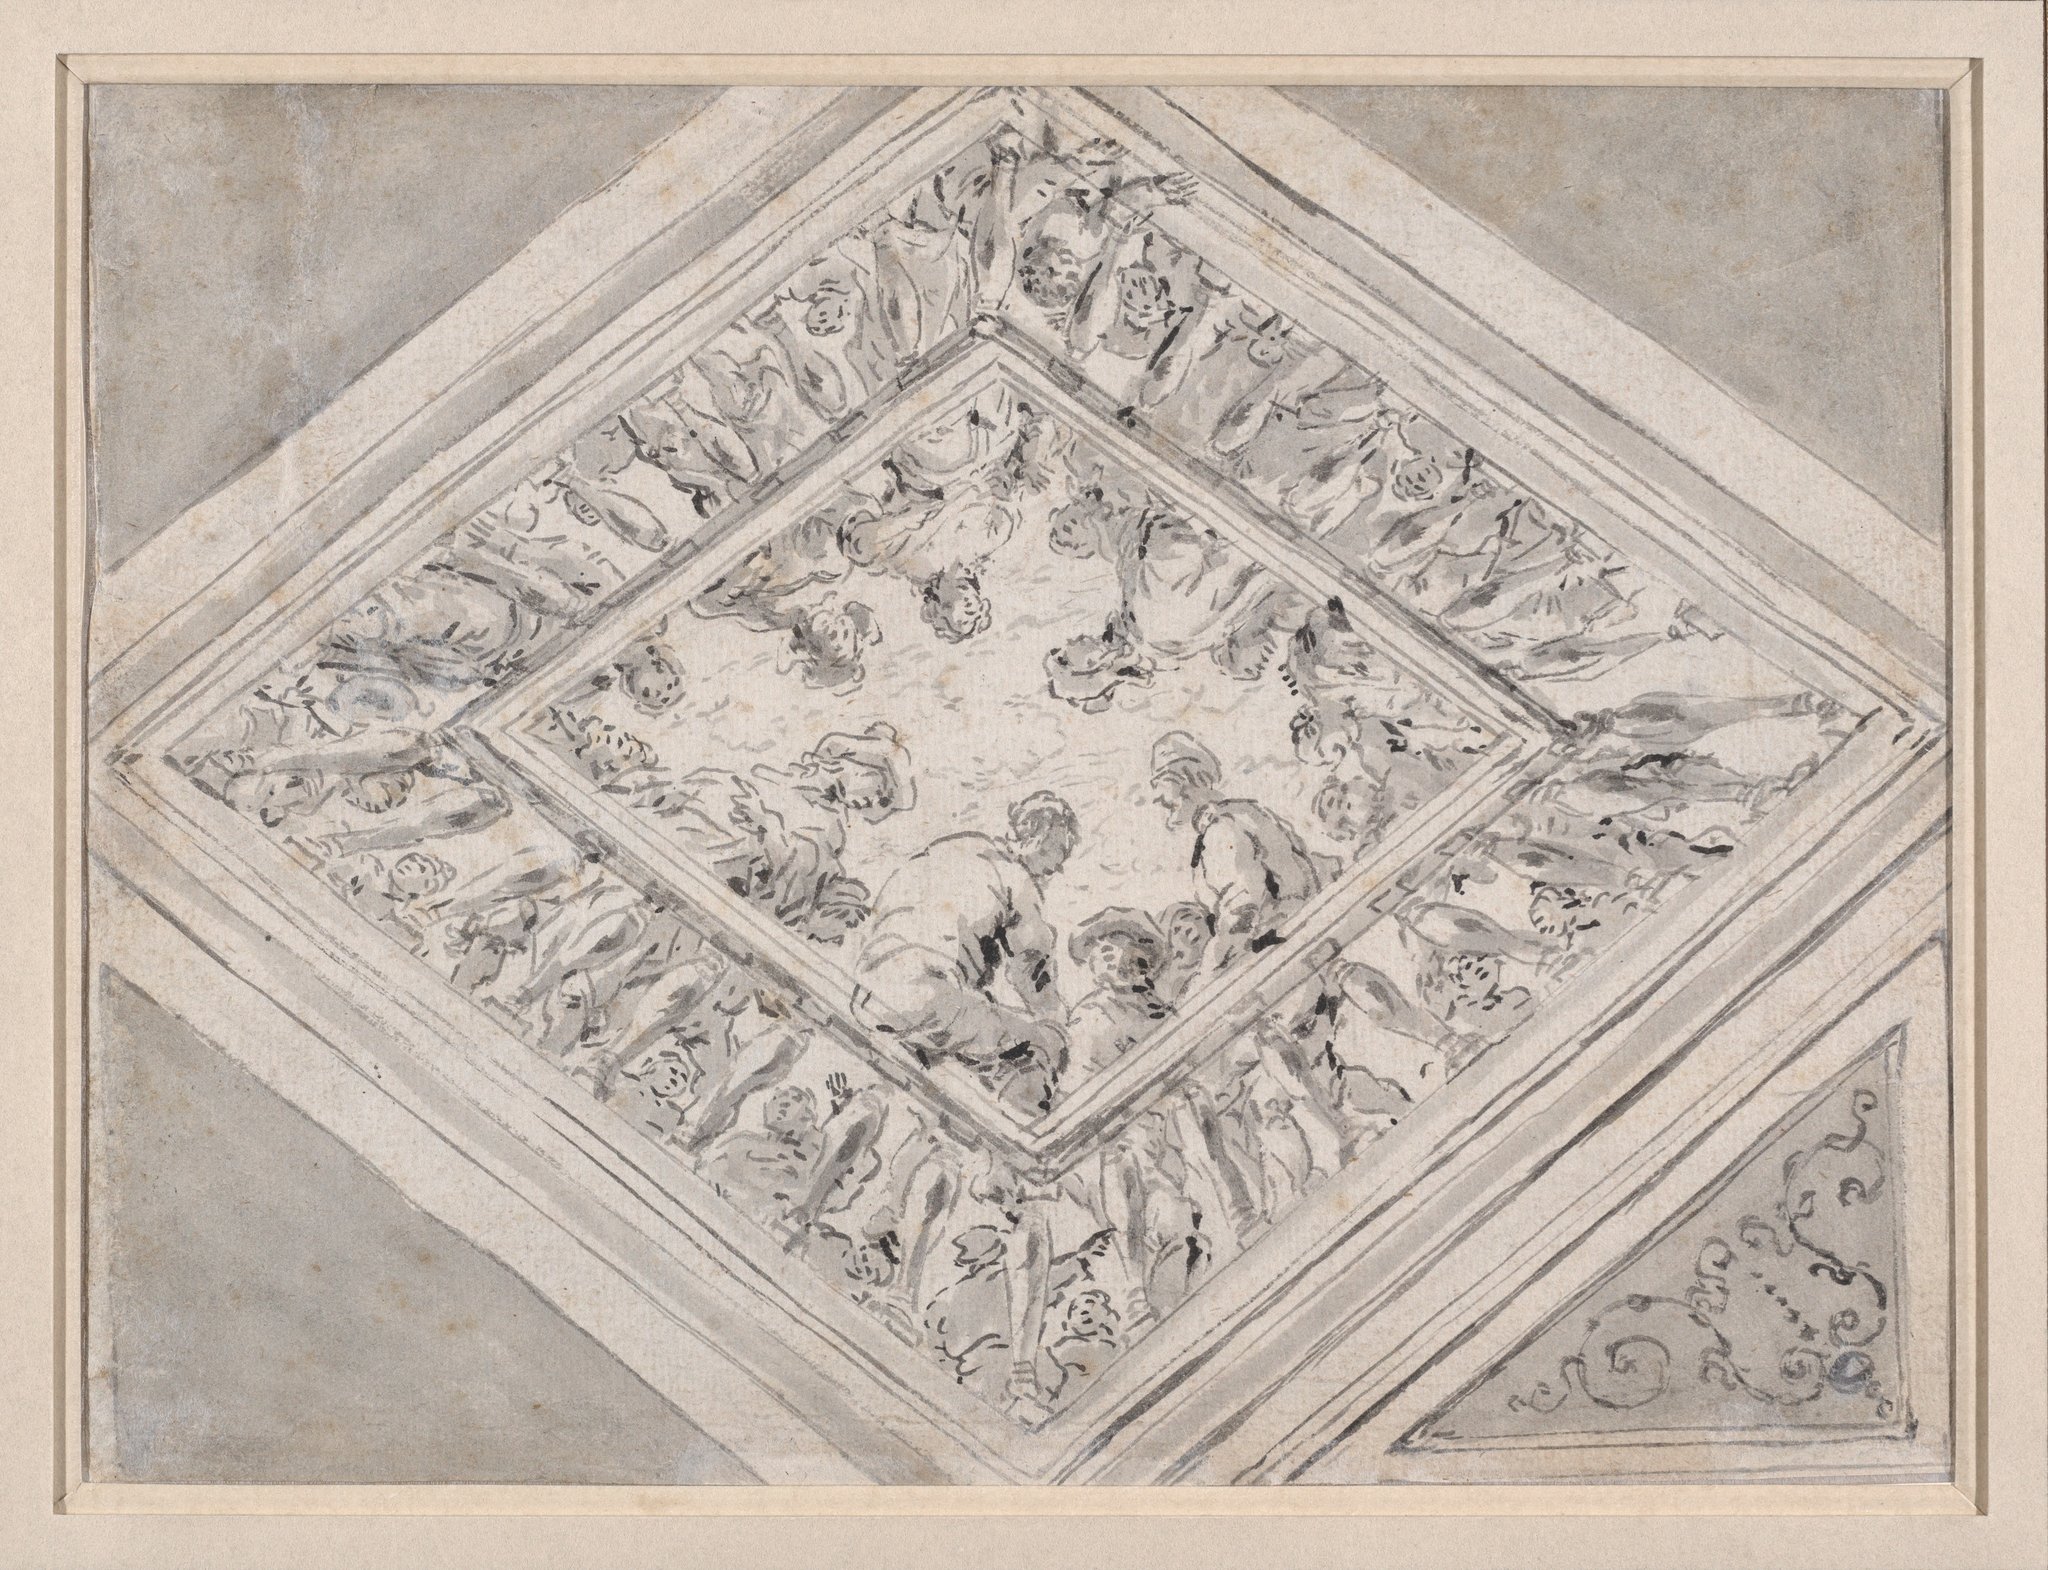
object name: drawing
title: Ceiling Design with Figures along a Lozenge-Shaped Balustrade (recto); Alternative Design with Groups of Figures along a Lozenge-Shaped Window (verso)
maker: leonaert bramer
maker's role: artist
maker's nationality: dutch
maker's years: 1596-1674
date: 1628-1674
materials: ink, paper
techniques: brush, wash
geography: netherlands